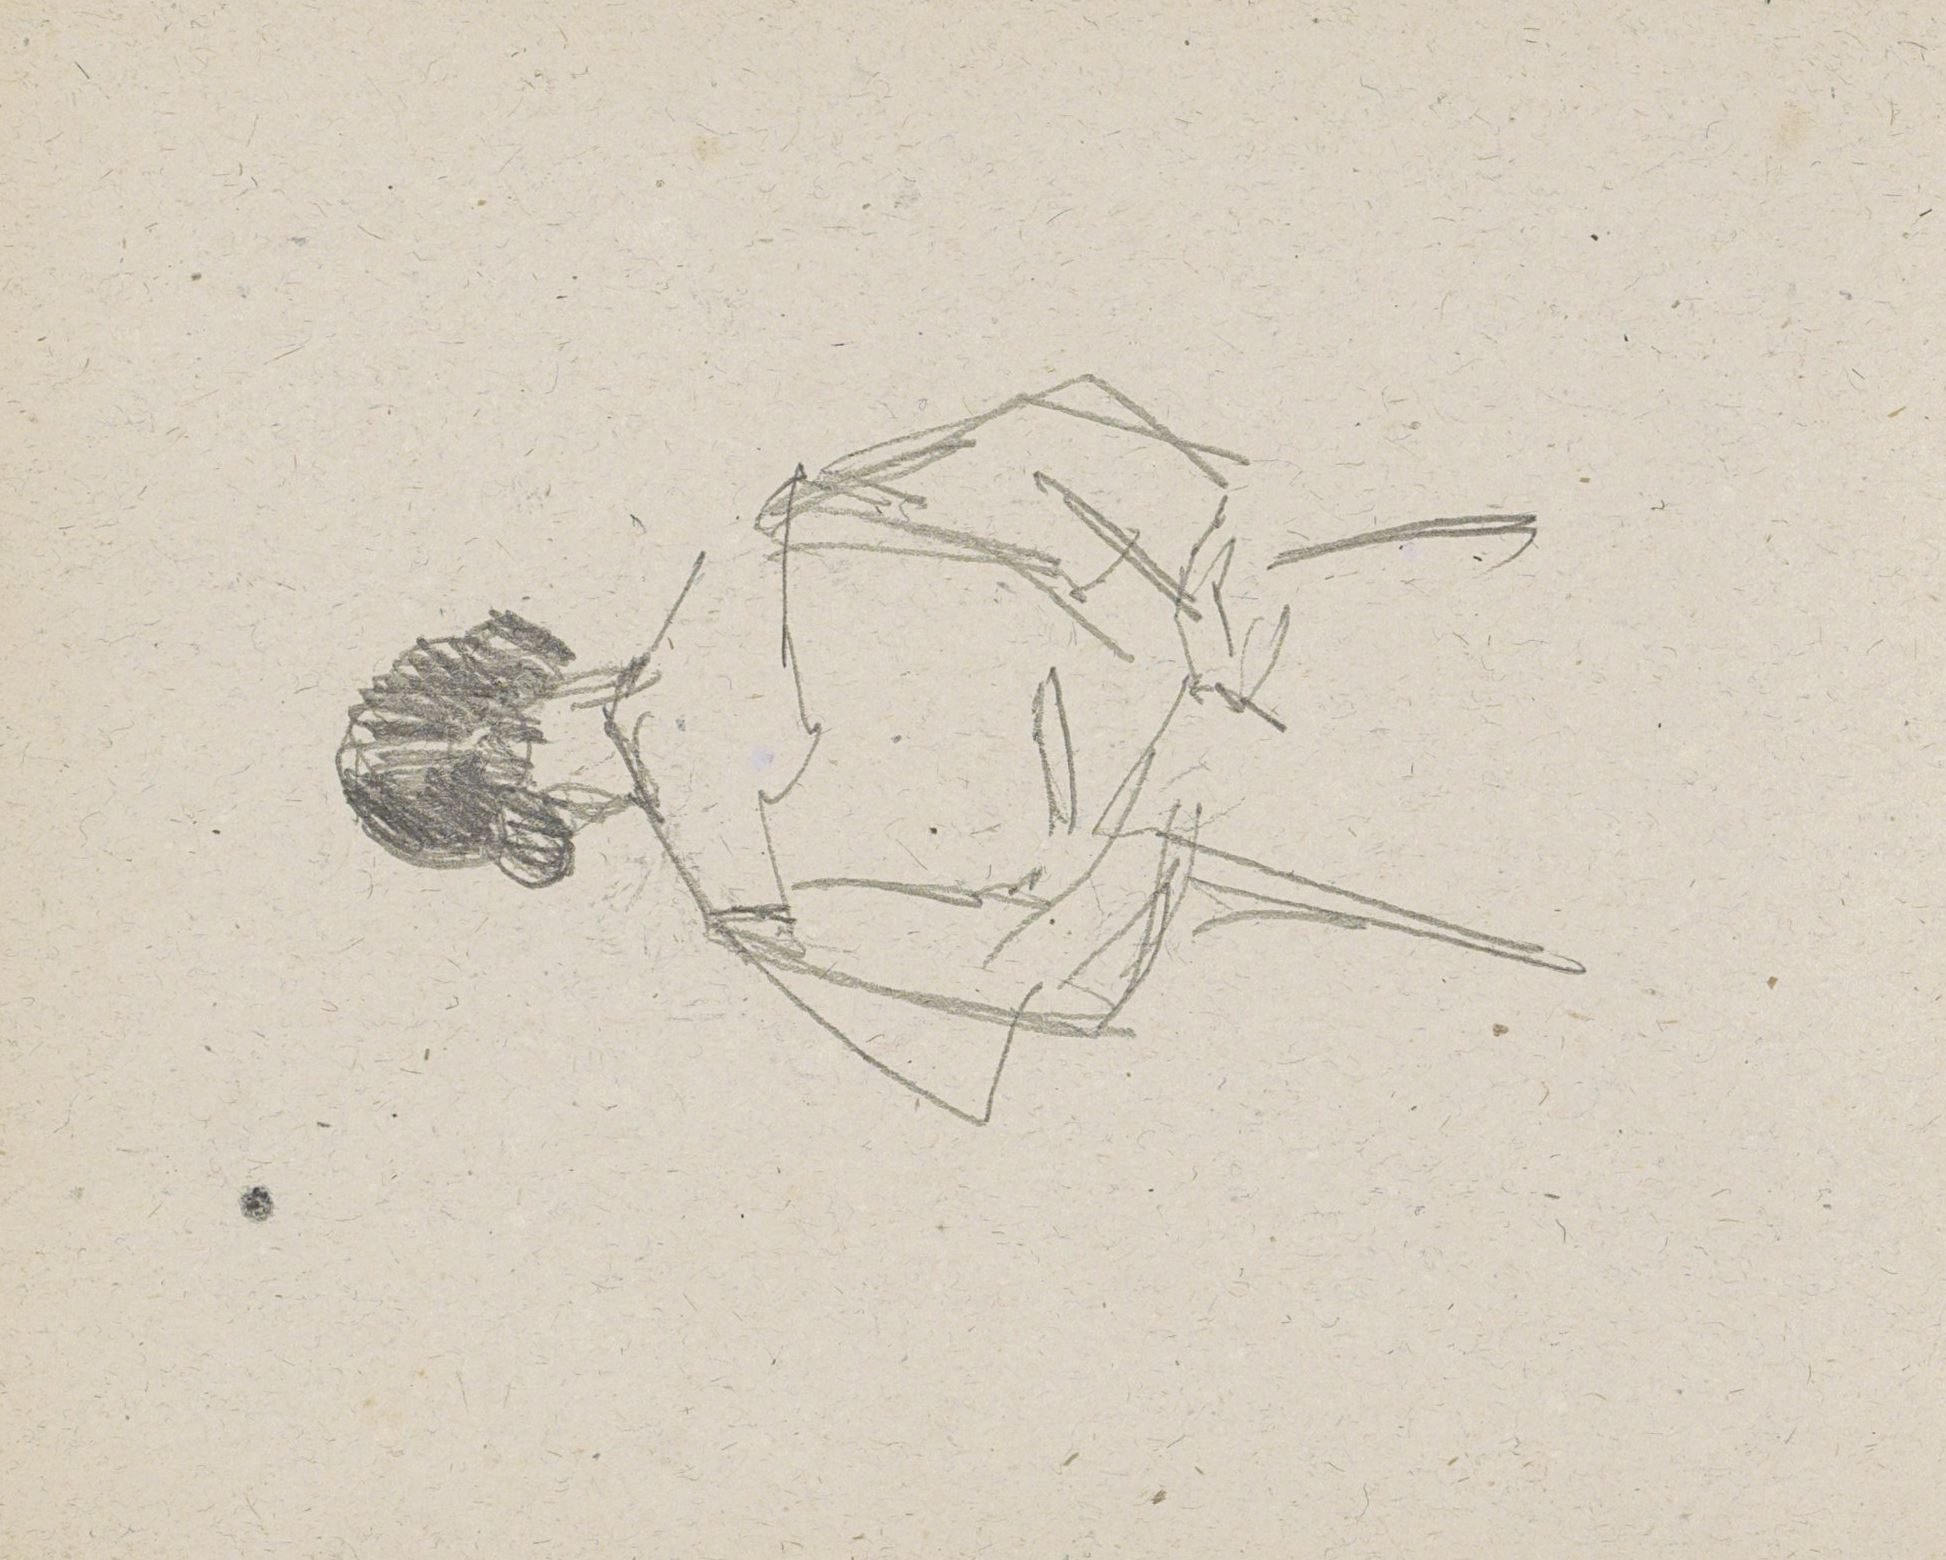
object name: sketchbook leaf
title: Staande vrouw, op de rug gezien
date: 1919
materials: paper, pencil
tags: adult woman (+ standing)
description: Met haar handen op haar rug. Pagina 27 uit schetsboek XXXV met 36 pagina's.